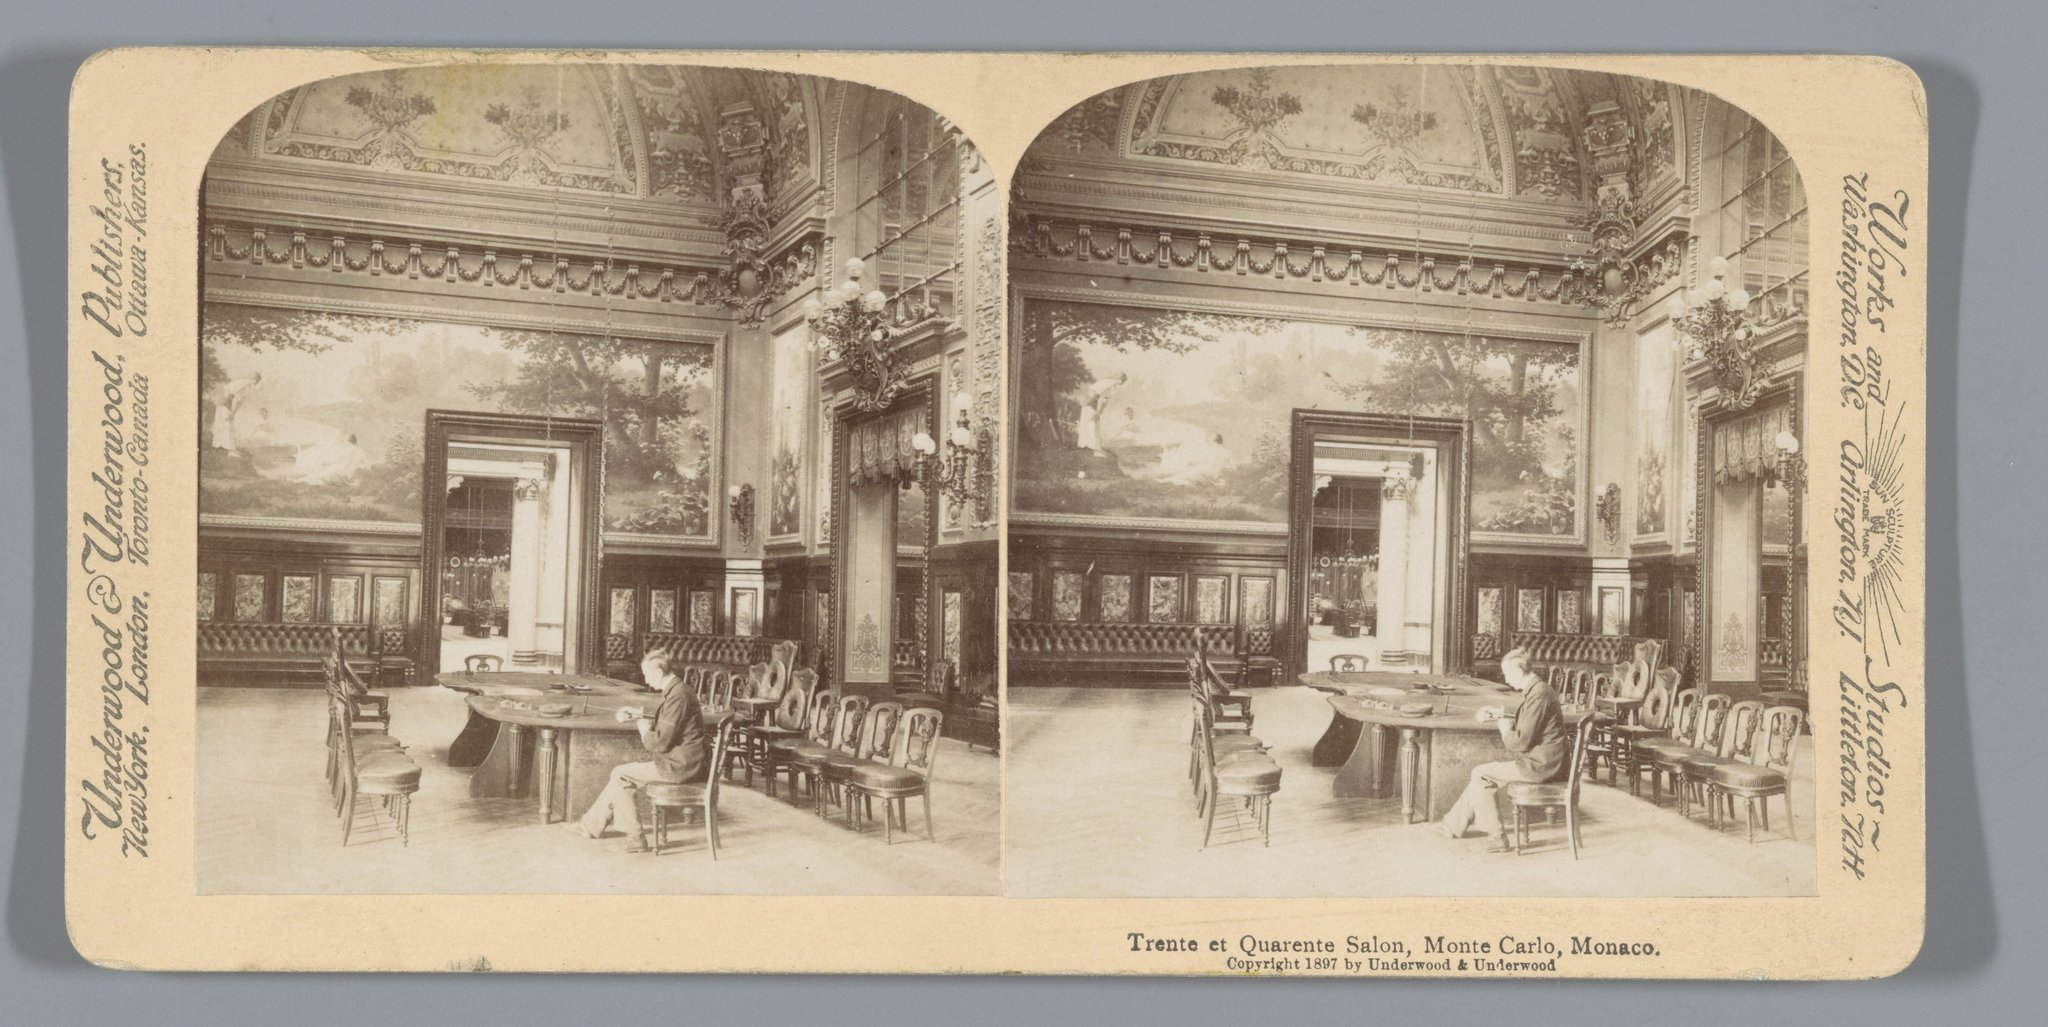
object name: stereograph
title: Zaal voor het spel Trent et Quarante in het Monte Carlo Casino in Monte-Carlo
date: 1897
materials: cardboard, photographic support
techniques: albumen print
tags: casino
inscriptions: inscription